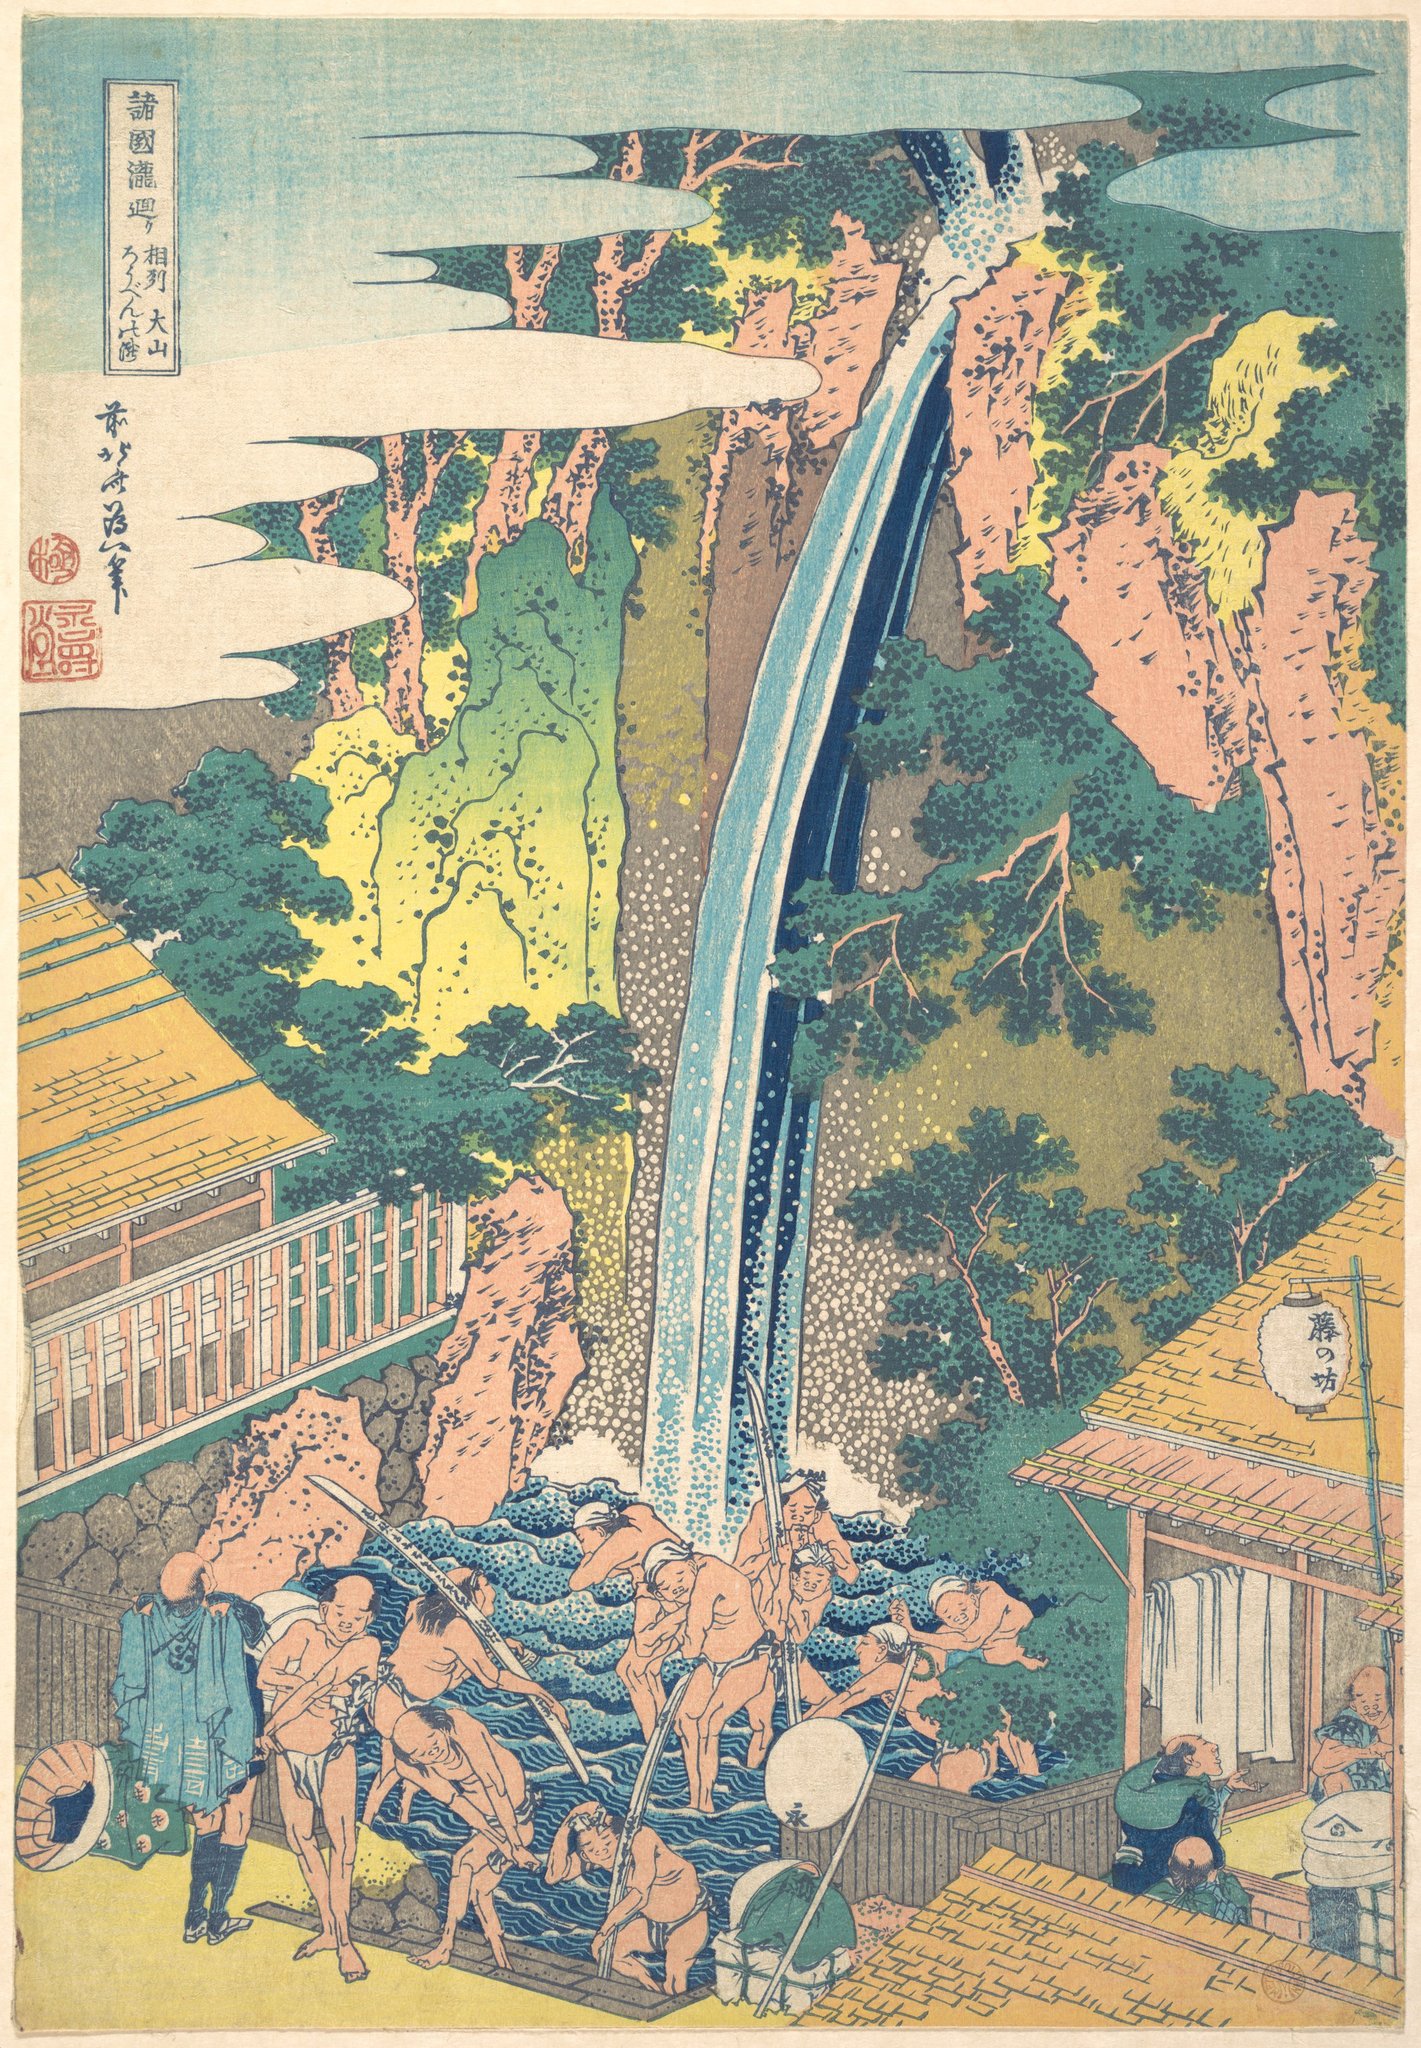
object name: woodblock print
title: Rōben Waterfall at Ōyama in Sagami Province (Sōshū Ōyama Rōben no taki), from the series A Tour of Waterfalls in Various Provinces (Shokoku taki meguri)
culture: japanese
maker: katsushika hokusai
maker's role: artist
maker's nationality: japanese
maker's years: 1760-1849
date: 1827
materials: ink, paper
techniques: woodblock print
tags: houses,men,waterfalls,trees